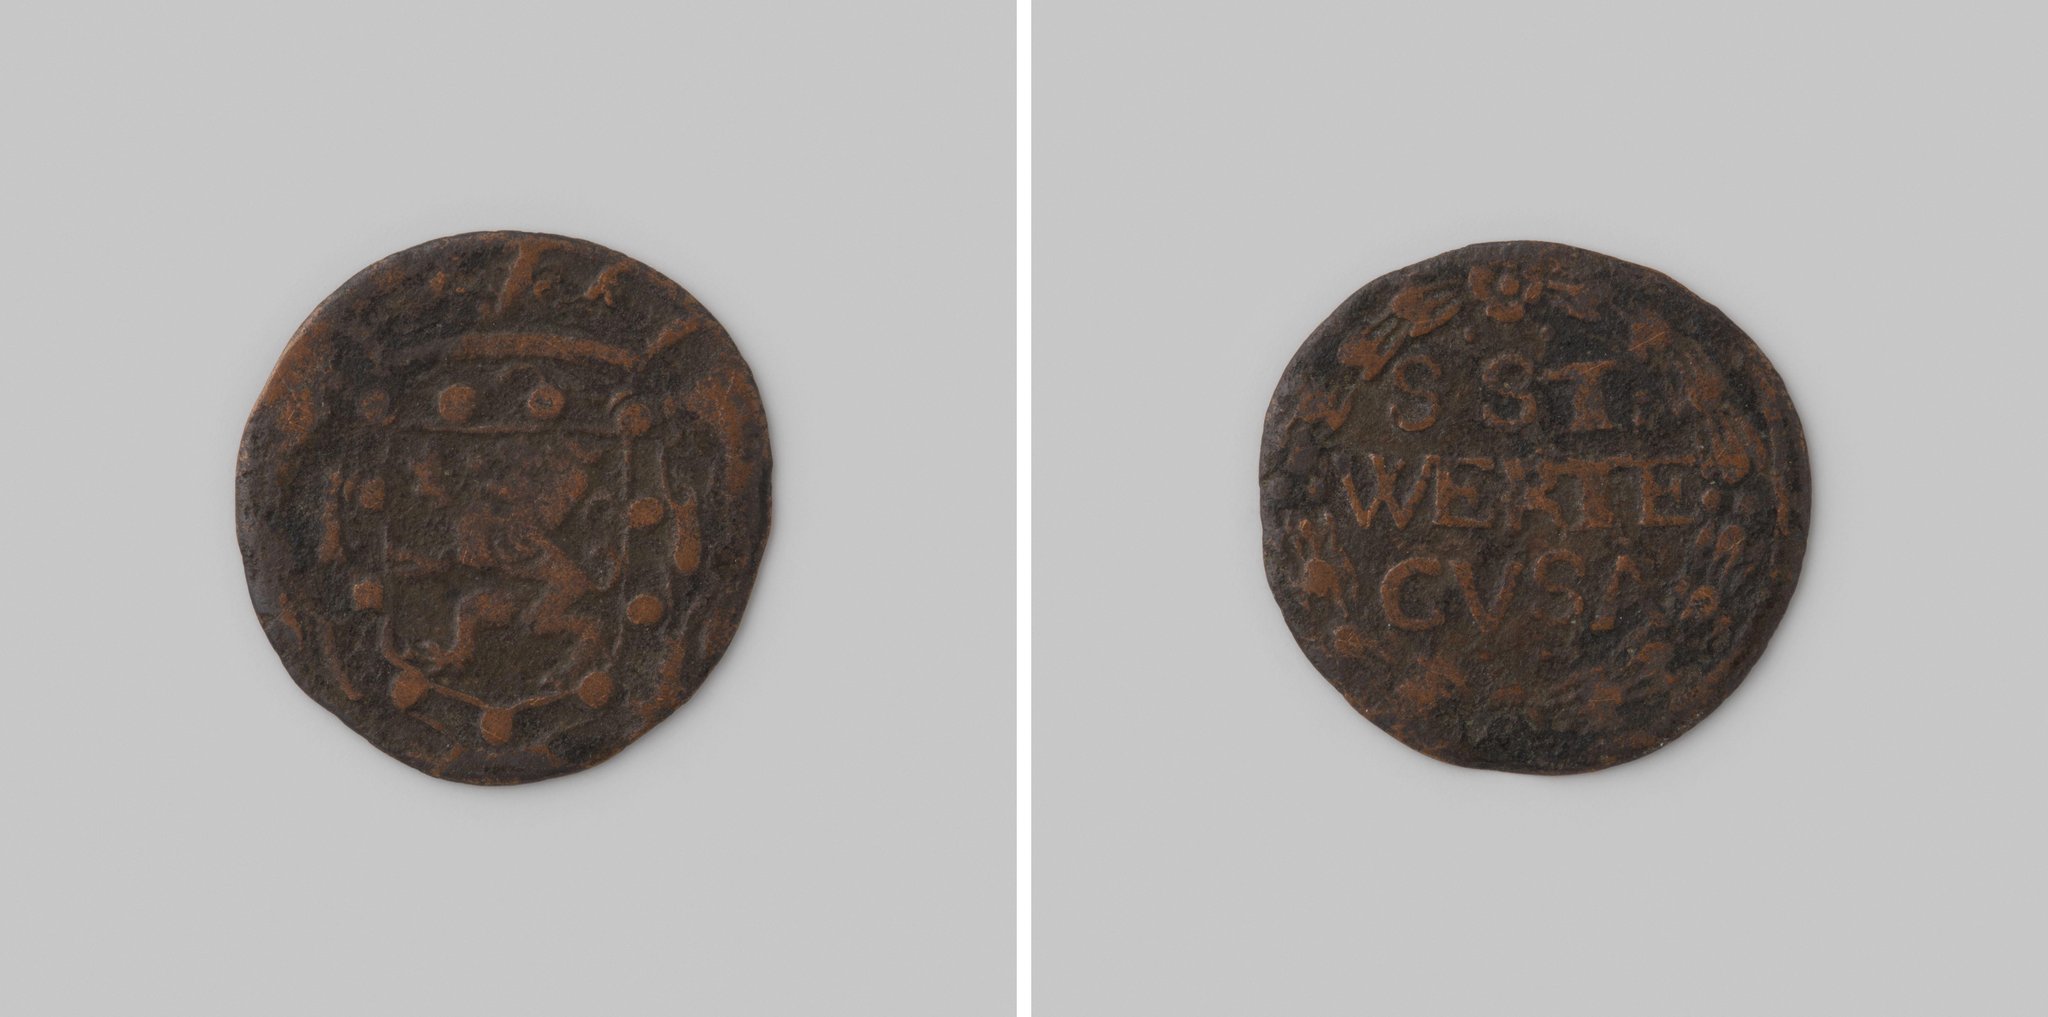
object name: coin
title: Stevenweertse duit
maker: herman frederik van den bergh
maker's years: 1600-1669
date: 1620-1632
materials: copper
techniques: striking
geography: stevensweert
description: Koperen munt. Voorzijde: tussen twee bladerkransen gekroond wapenschild van Van den Bergh. Keerzijde: binnen een bladerkrans opschrift SST/WERTE/CVSA in drie regels.